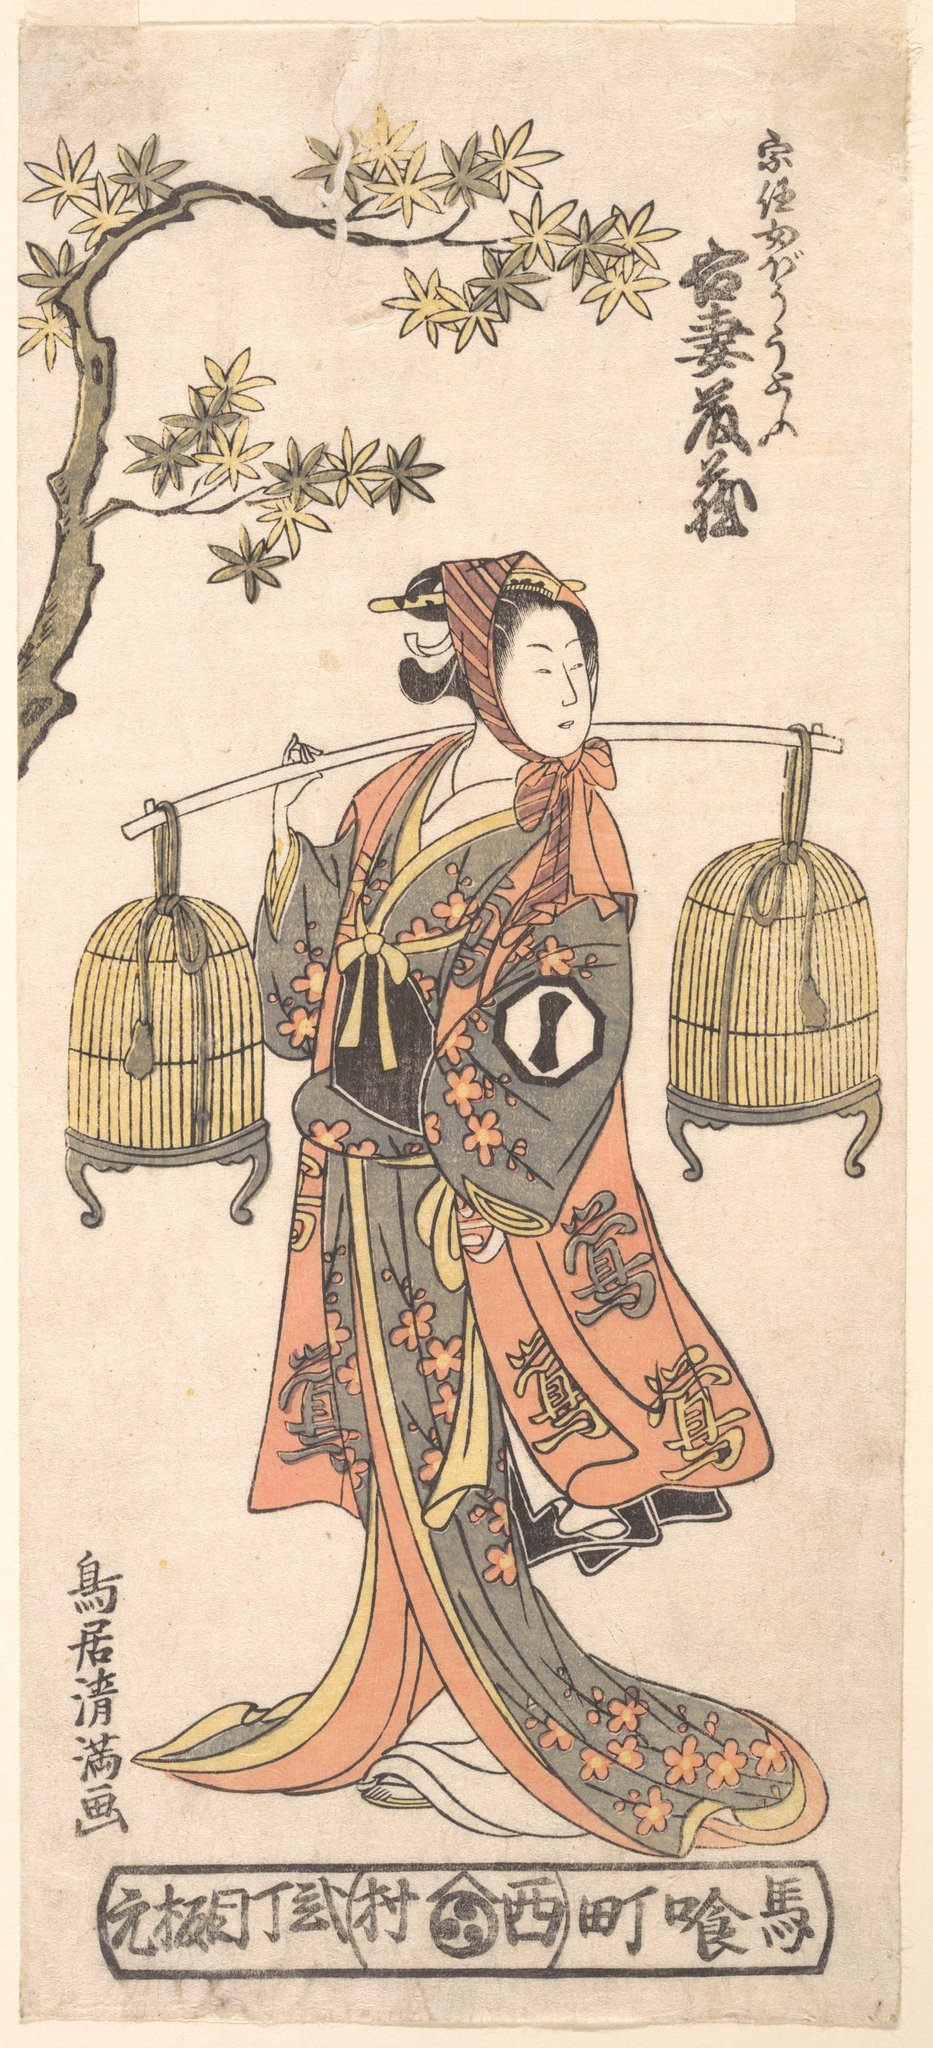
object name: print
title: The Actor Azuma Tōzō I as a Woman Carrying Two Bird Cages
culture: japanese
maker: torii kiyomitsu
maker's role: artist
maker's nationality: japanese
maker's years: 1735-1785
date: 1768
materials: ink, paper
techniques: woodblock print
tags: women,actors